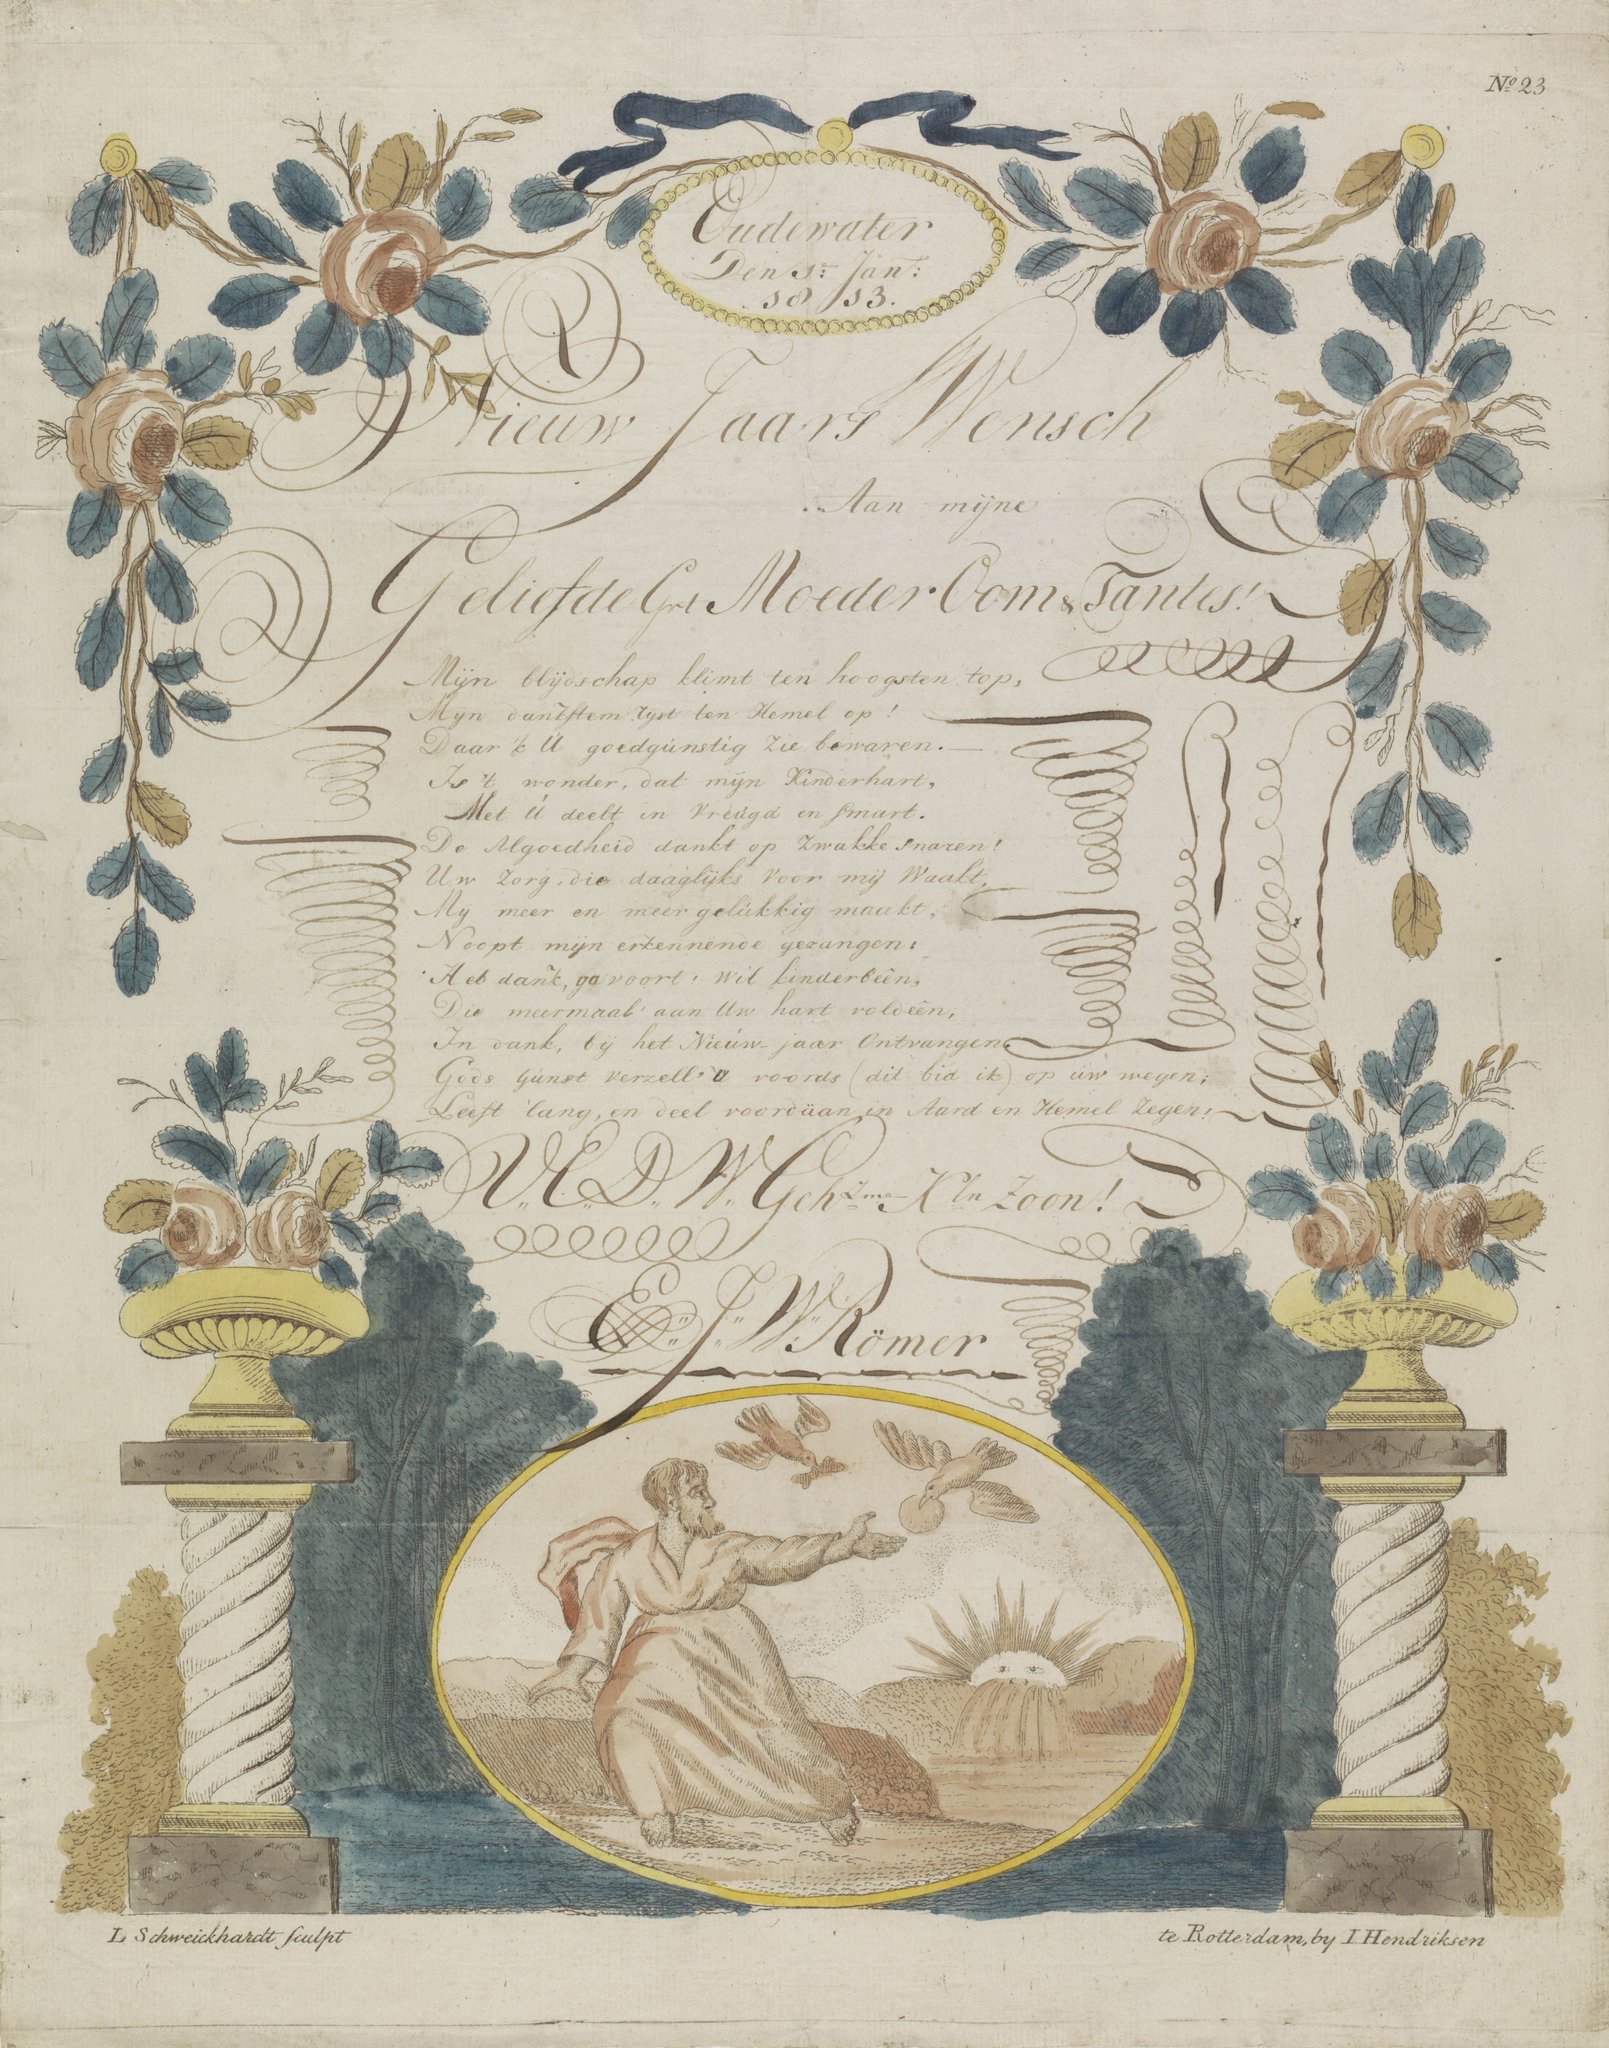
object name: wensbrief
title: Wensbrief met Elia gevoed door raven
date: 1813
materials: ink, paper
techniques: calligraphy, colour, etching, pen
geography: rotterdam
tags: elijah fed by the raven(s): while the prophet is living by the brook, ravens bring him food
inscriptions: inscription: ‘Nieuw jaars wensch / Aan mijne / Geliefde grt moeder oom & tantes! / Mijn blijdschap klimt ten hoogsten top ...’, collector's mark: Lugt 2228, collector's mark: Lugt 2760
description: Wensbrief met beschreven cartouche binnen een decoratief kader met een voorstelling van Elia die wordt gevoed door raven. Handgeschreven bericht in kalligrafie (Nieuwjaarswens) door E.J.W. Römer aan zijn grootmoeder, oom en tantes. Genummerd rechtsboven: No. 23